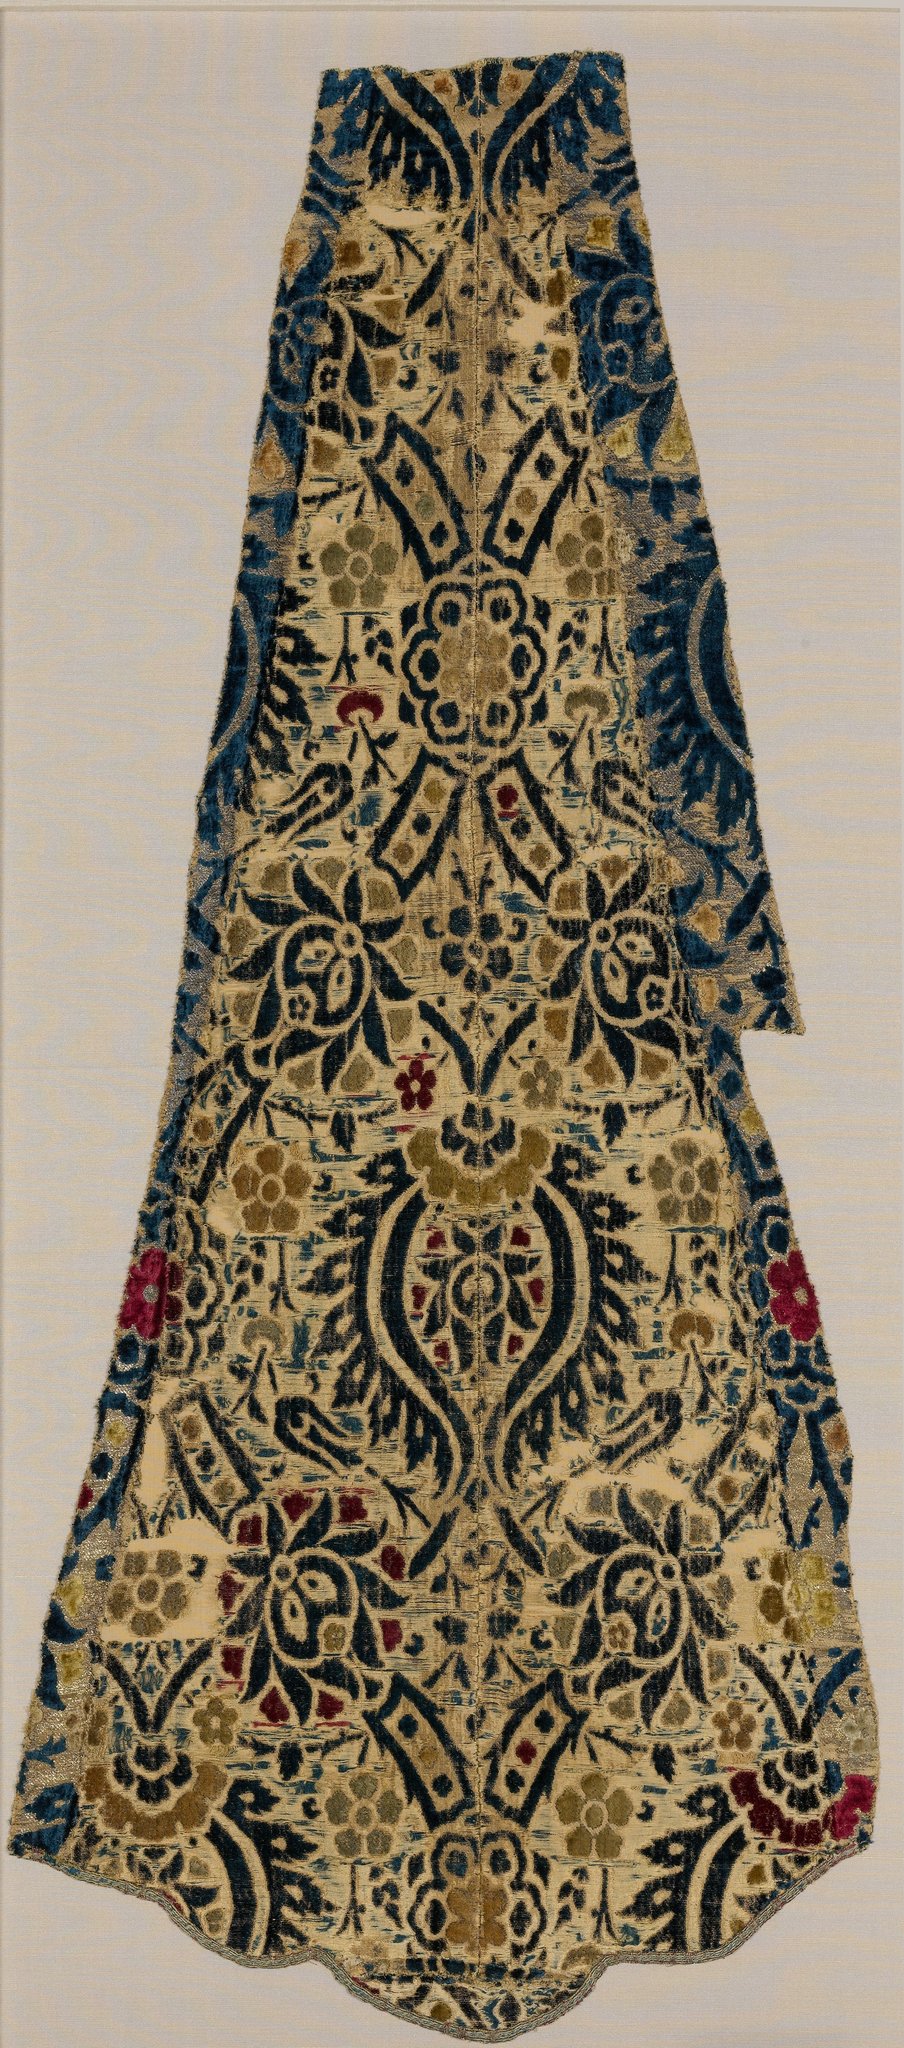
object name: fragment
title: Textile Fragment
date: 1540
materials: metal thread, silk, velvet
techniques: cutting, voiding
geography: iran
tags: flowers